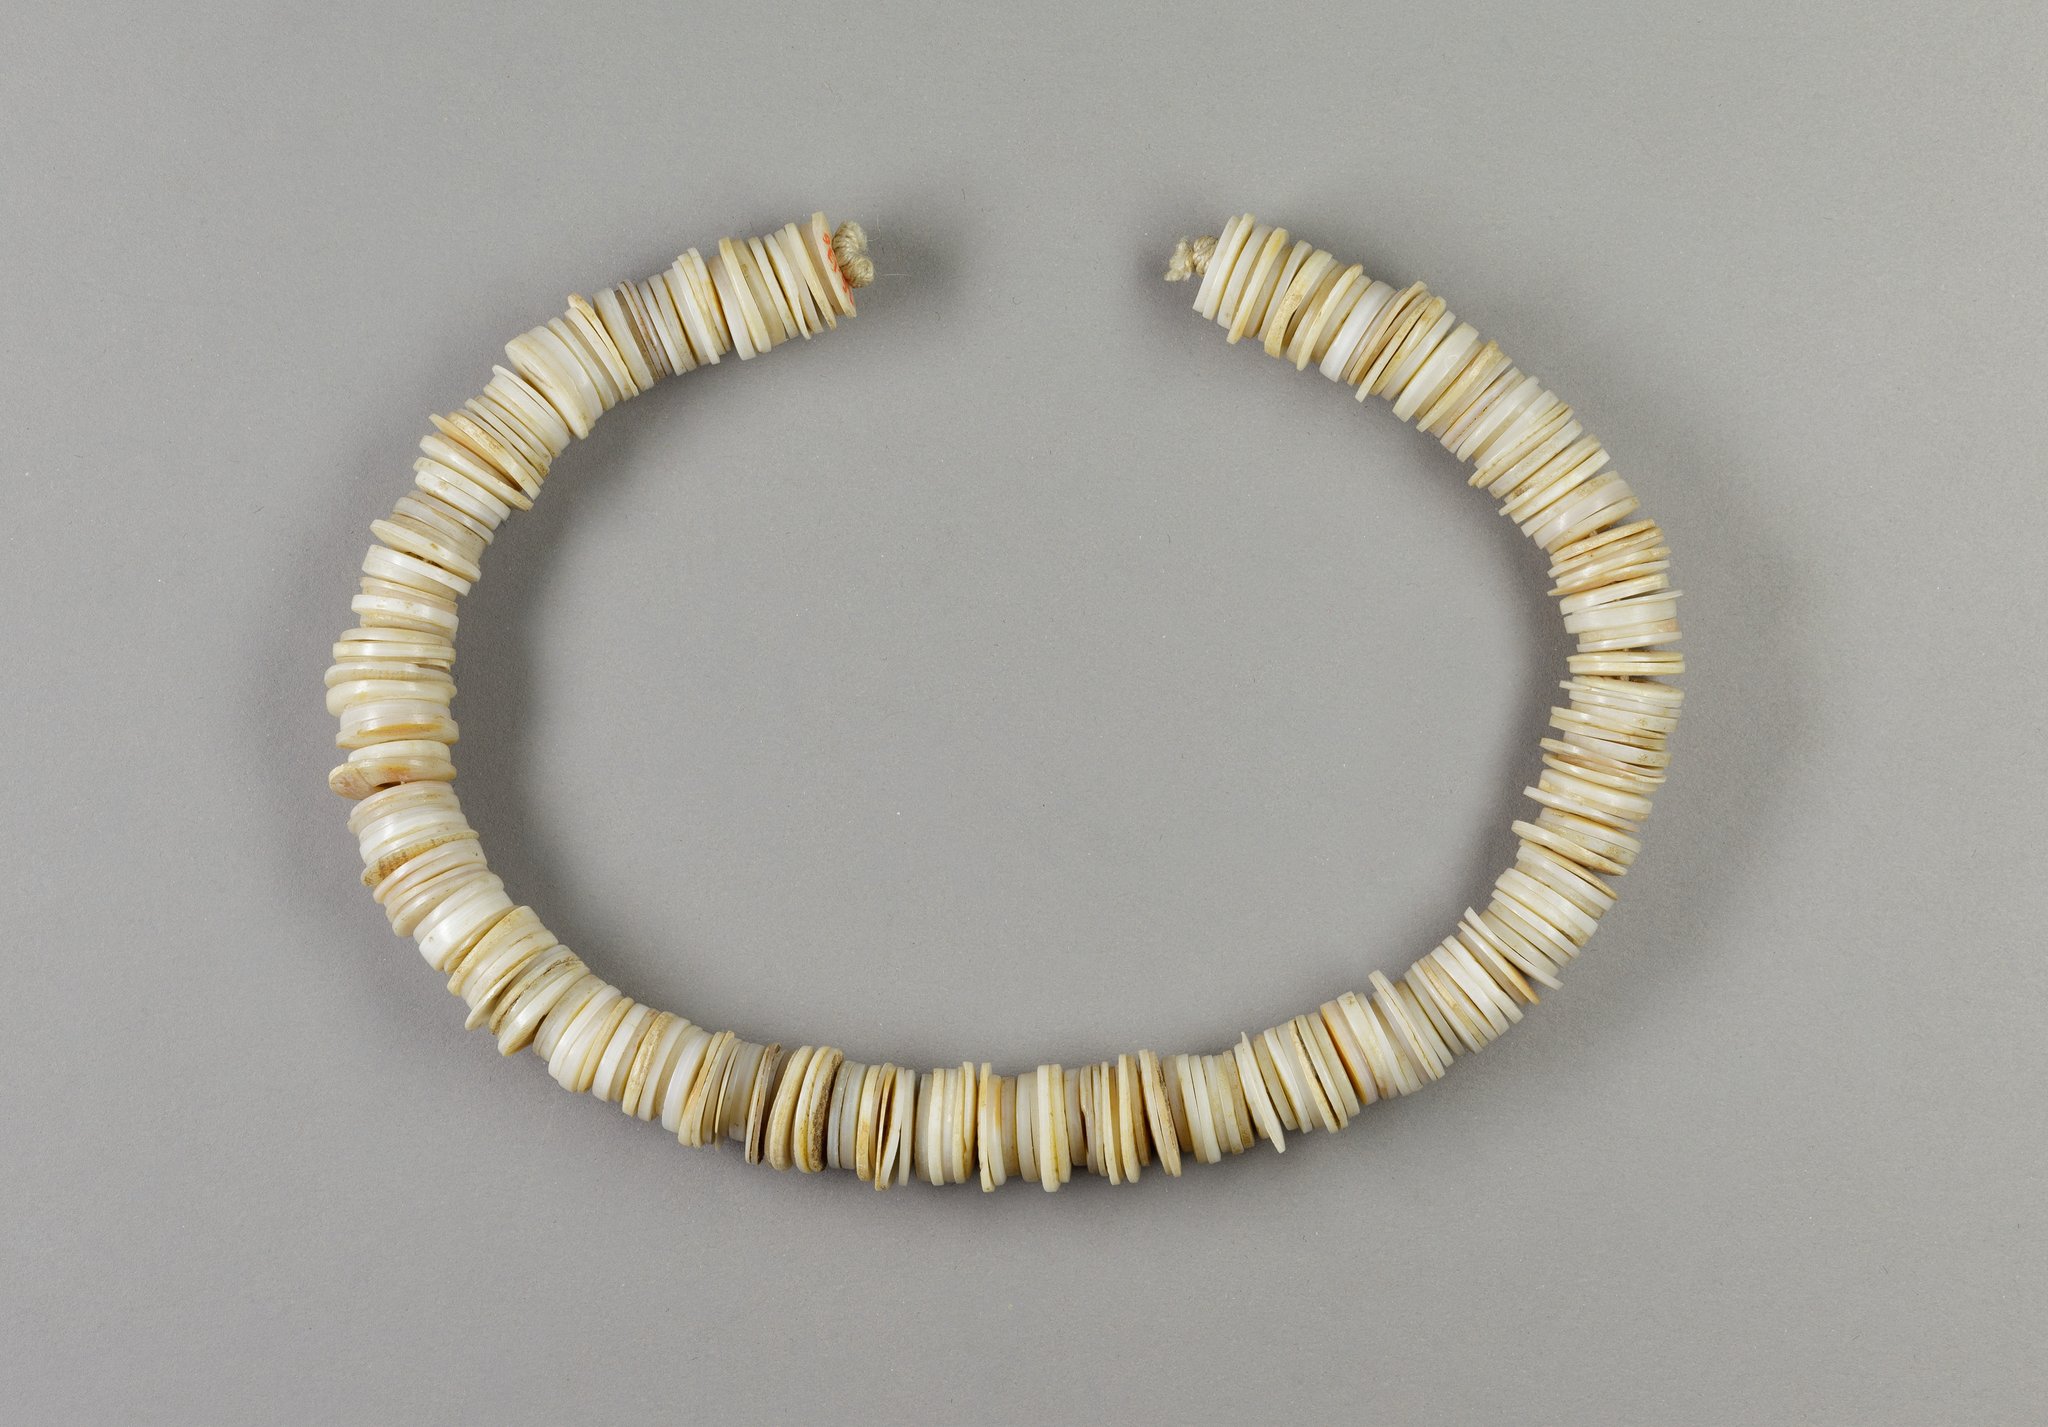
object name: bead, string, disk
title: String of Disk Beads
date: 1550-1070 BCE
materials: shell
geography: northern upper egypt